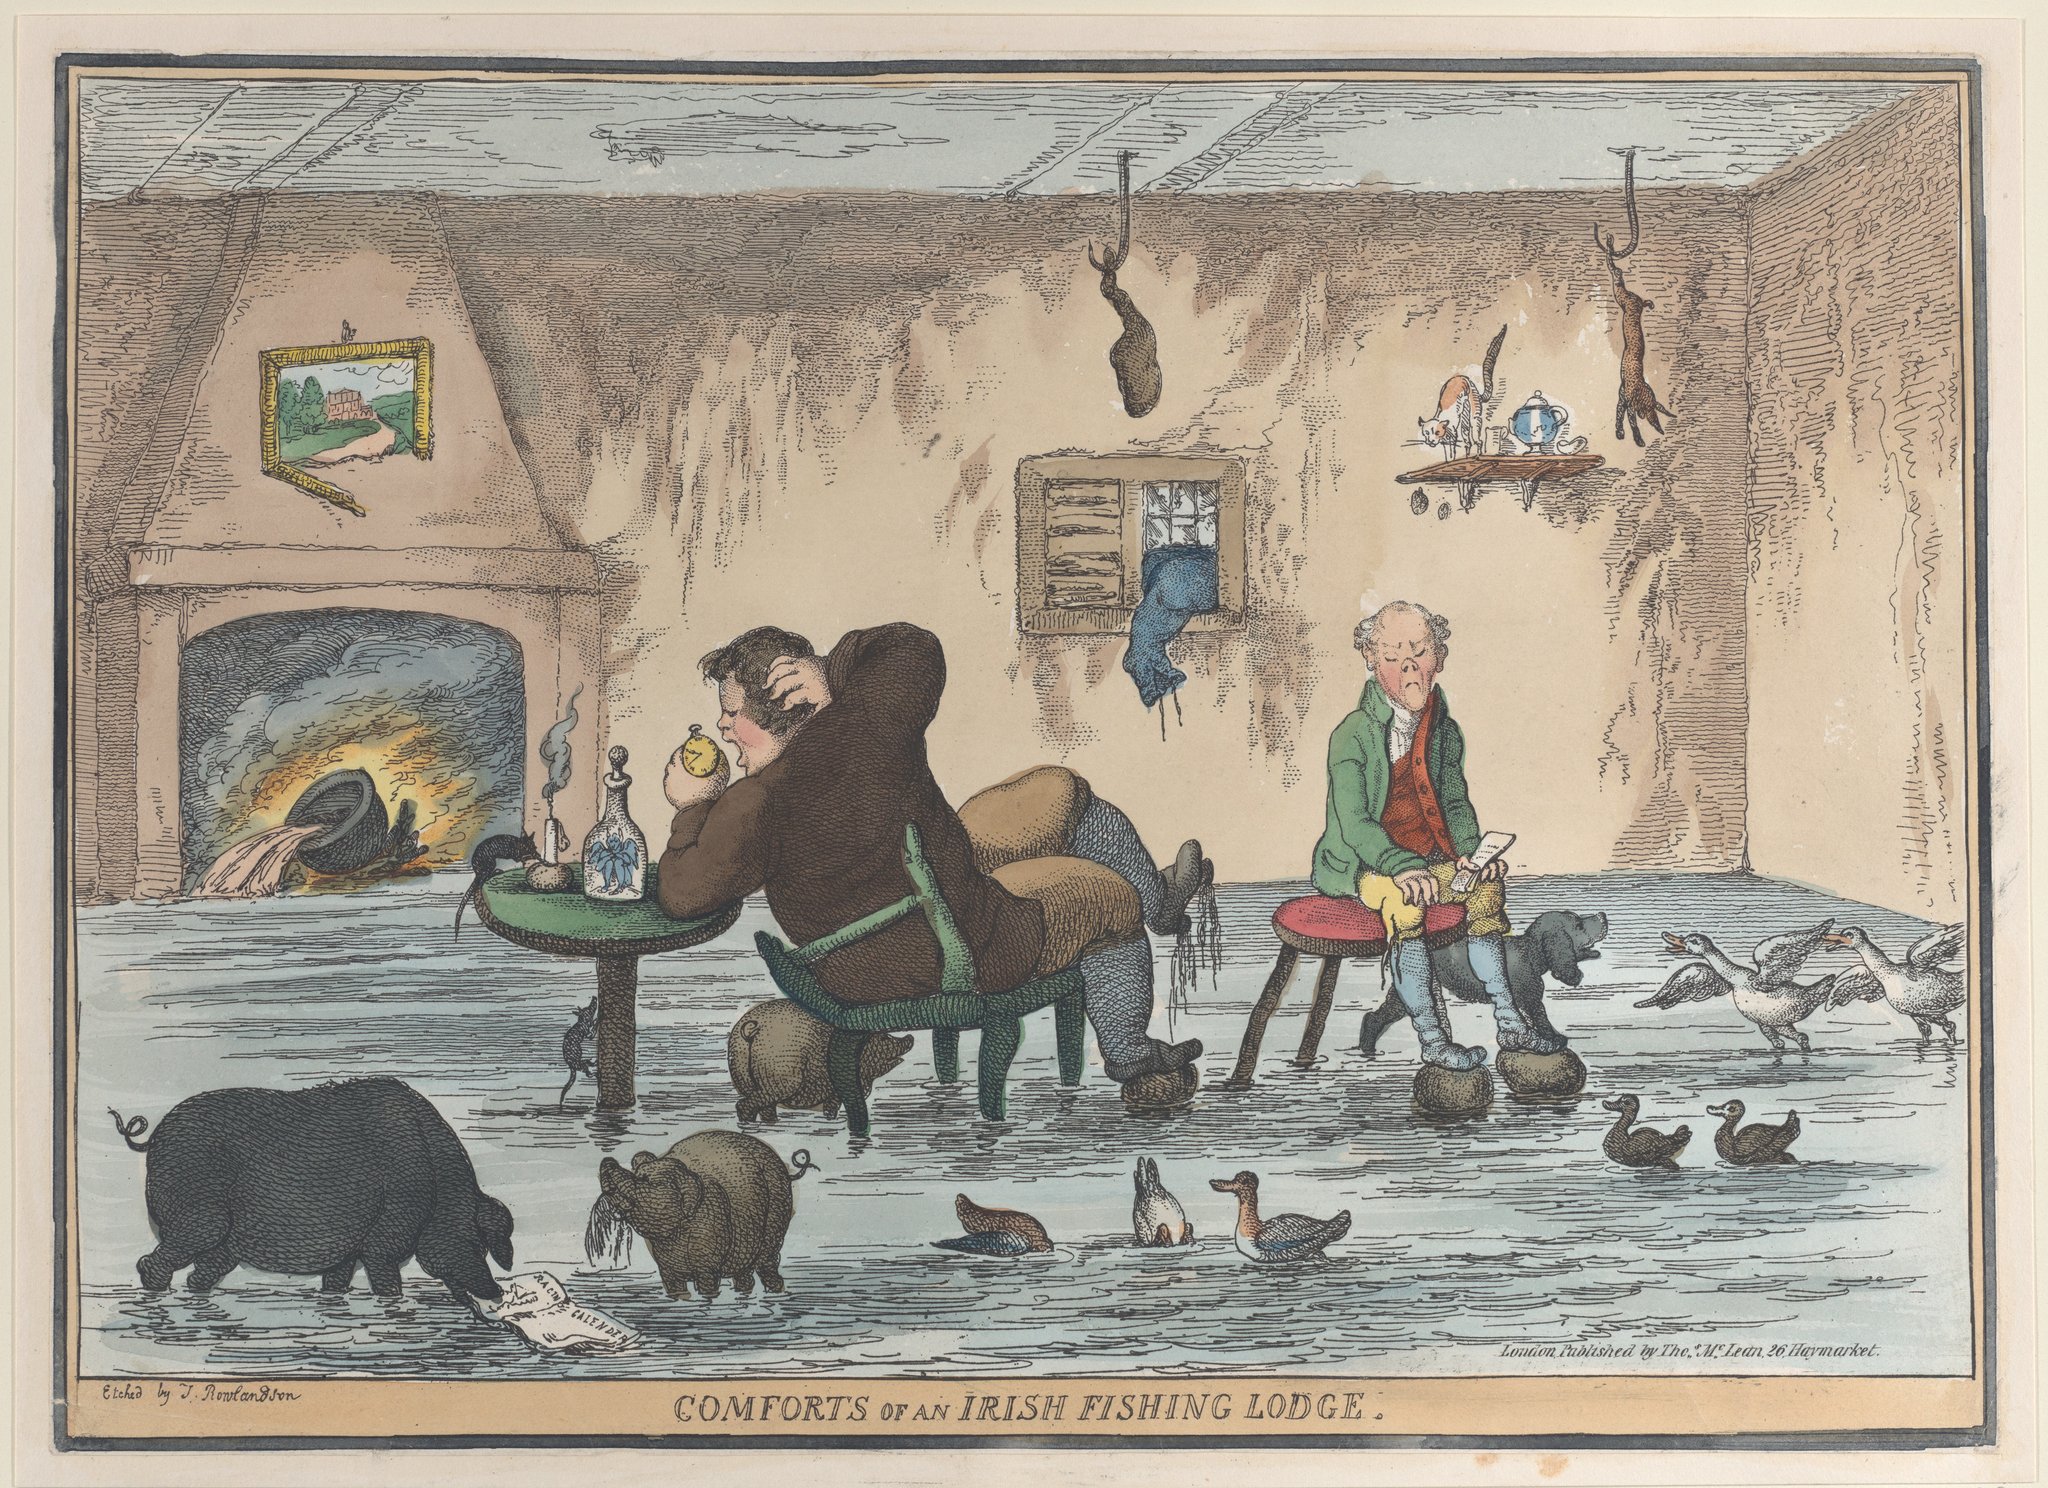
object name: print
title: Comforts of an Irish Fishing Lodge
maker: thomas rowlandson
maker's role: artist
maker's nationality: british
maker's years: 1757-1827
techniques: etching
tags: ducks,satire,men,dogs,pigs,floods